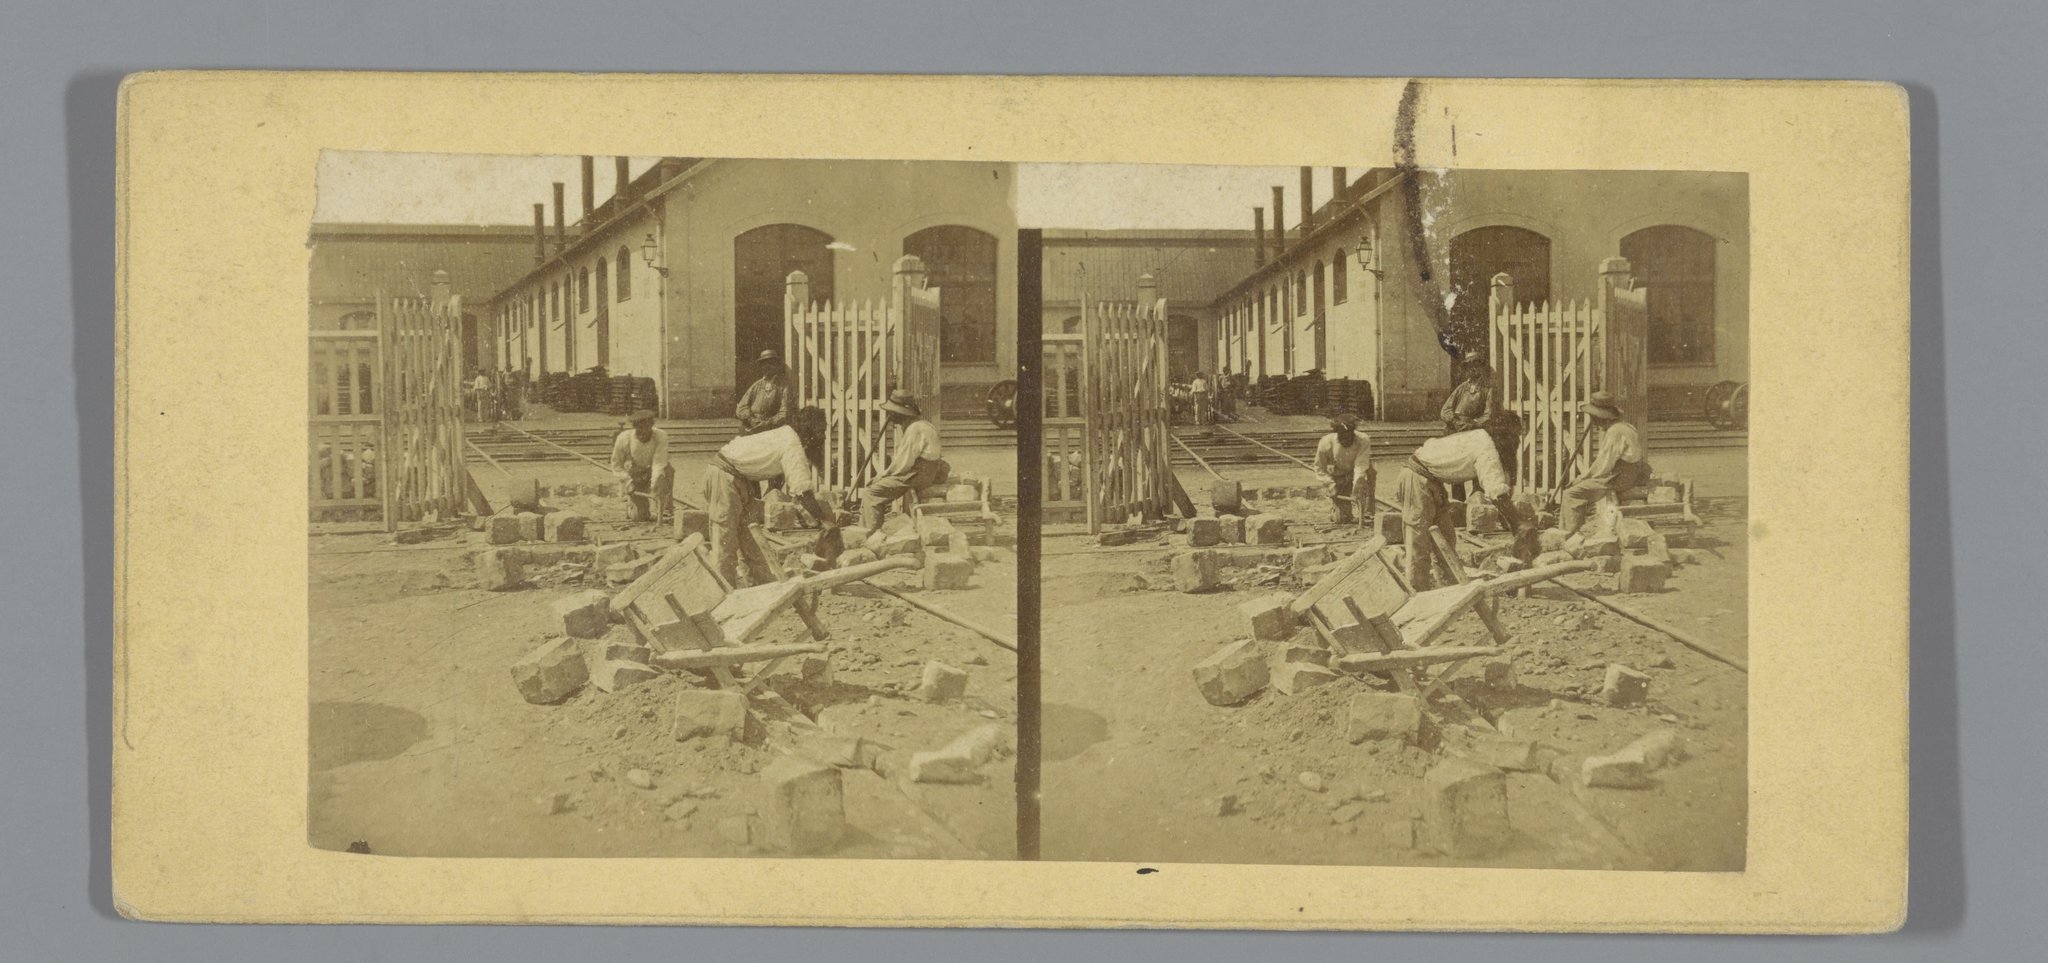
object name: stereograph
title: Wegarbeiders (vermoedelijk) te Frankrijk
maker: Anonymous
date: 1855-1865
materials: cardboard, photographic support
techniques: albumen print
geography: france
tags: working class, labourers, public road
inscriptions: inscription: ‘J Henry 10.’